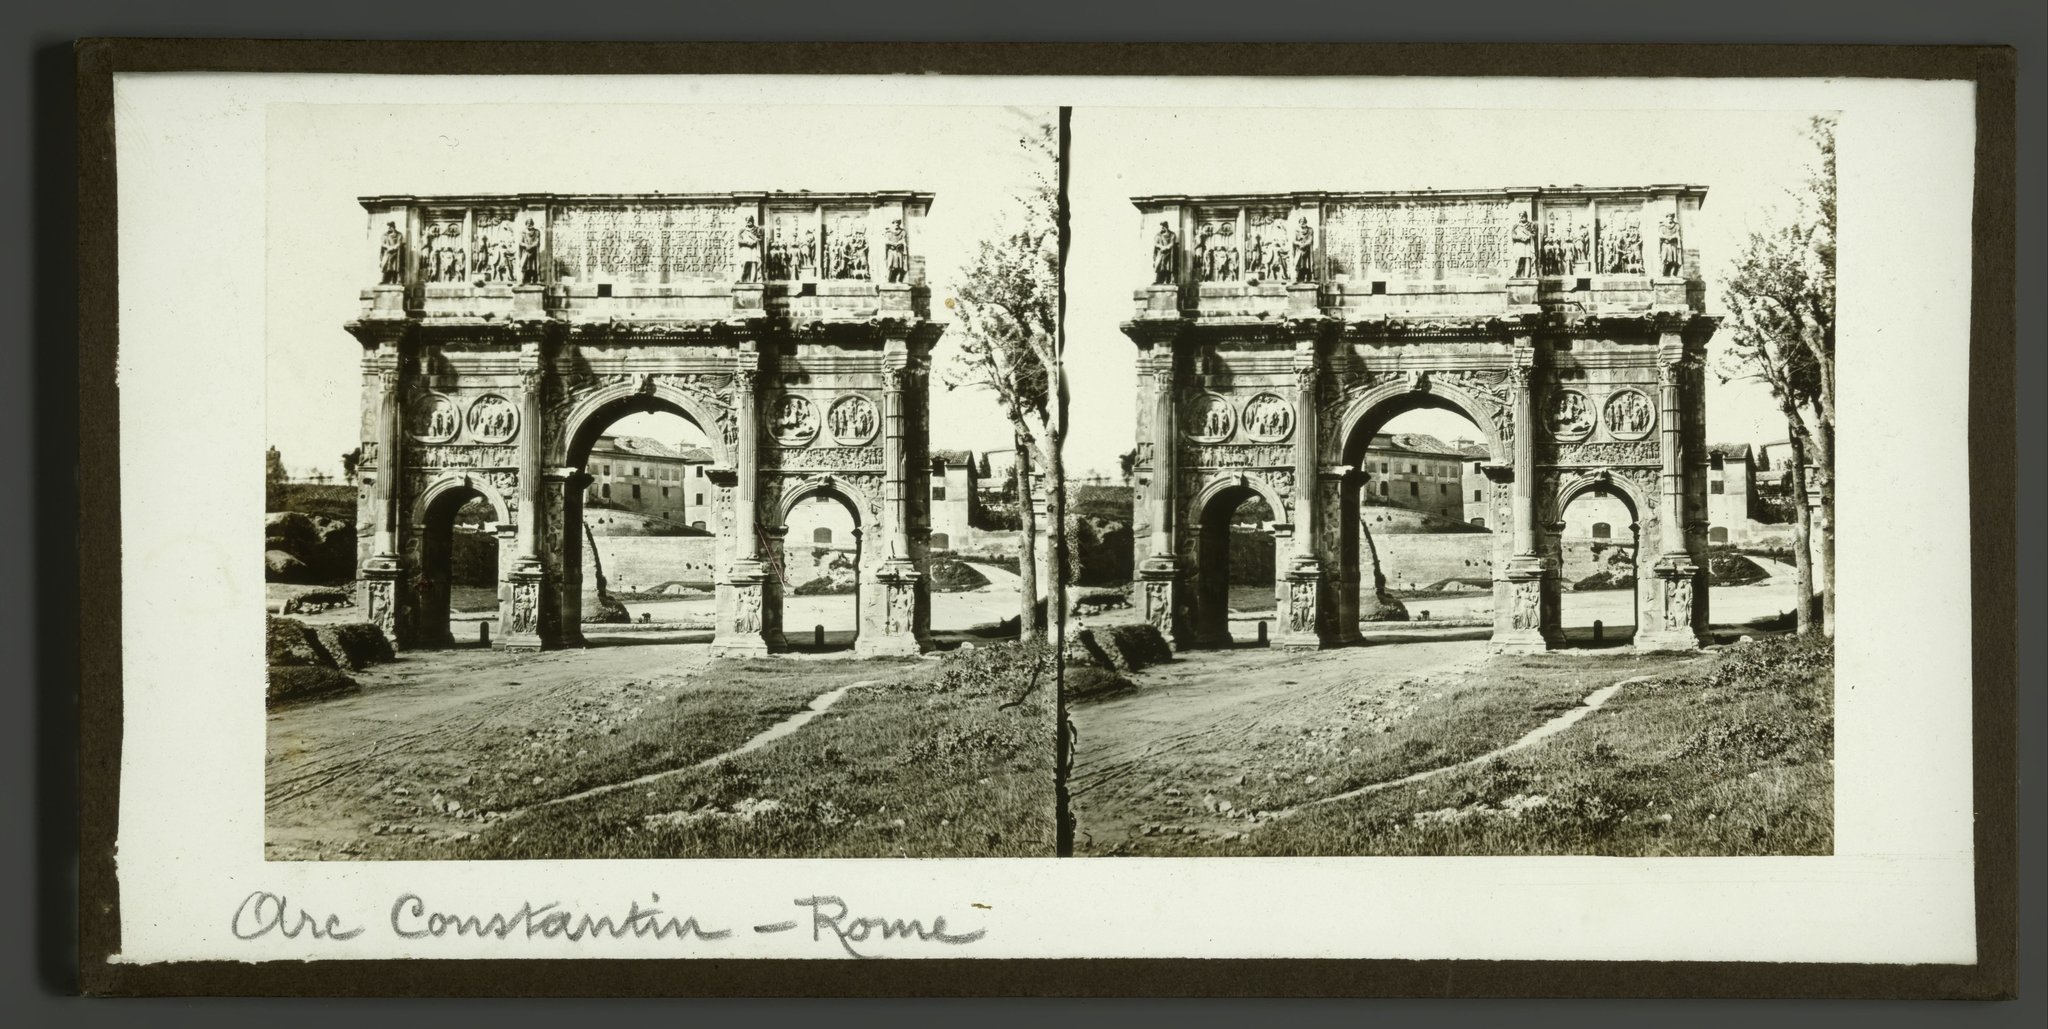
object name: stereoscopic photograph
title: Gezicht op de Boog van Constantijn te Rome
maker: Anonymous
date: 1856-1890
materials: glass, paper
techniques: slide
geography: rome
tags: triumphal arch, arch of constantine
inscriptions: annotation: ‘Arc Constantin - Rome’, annotation: ‘t:z/m:a’